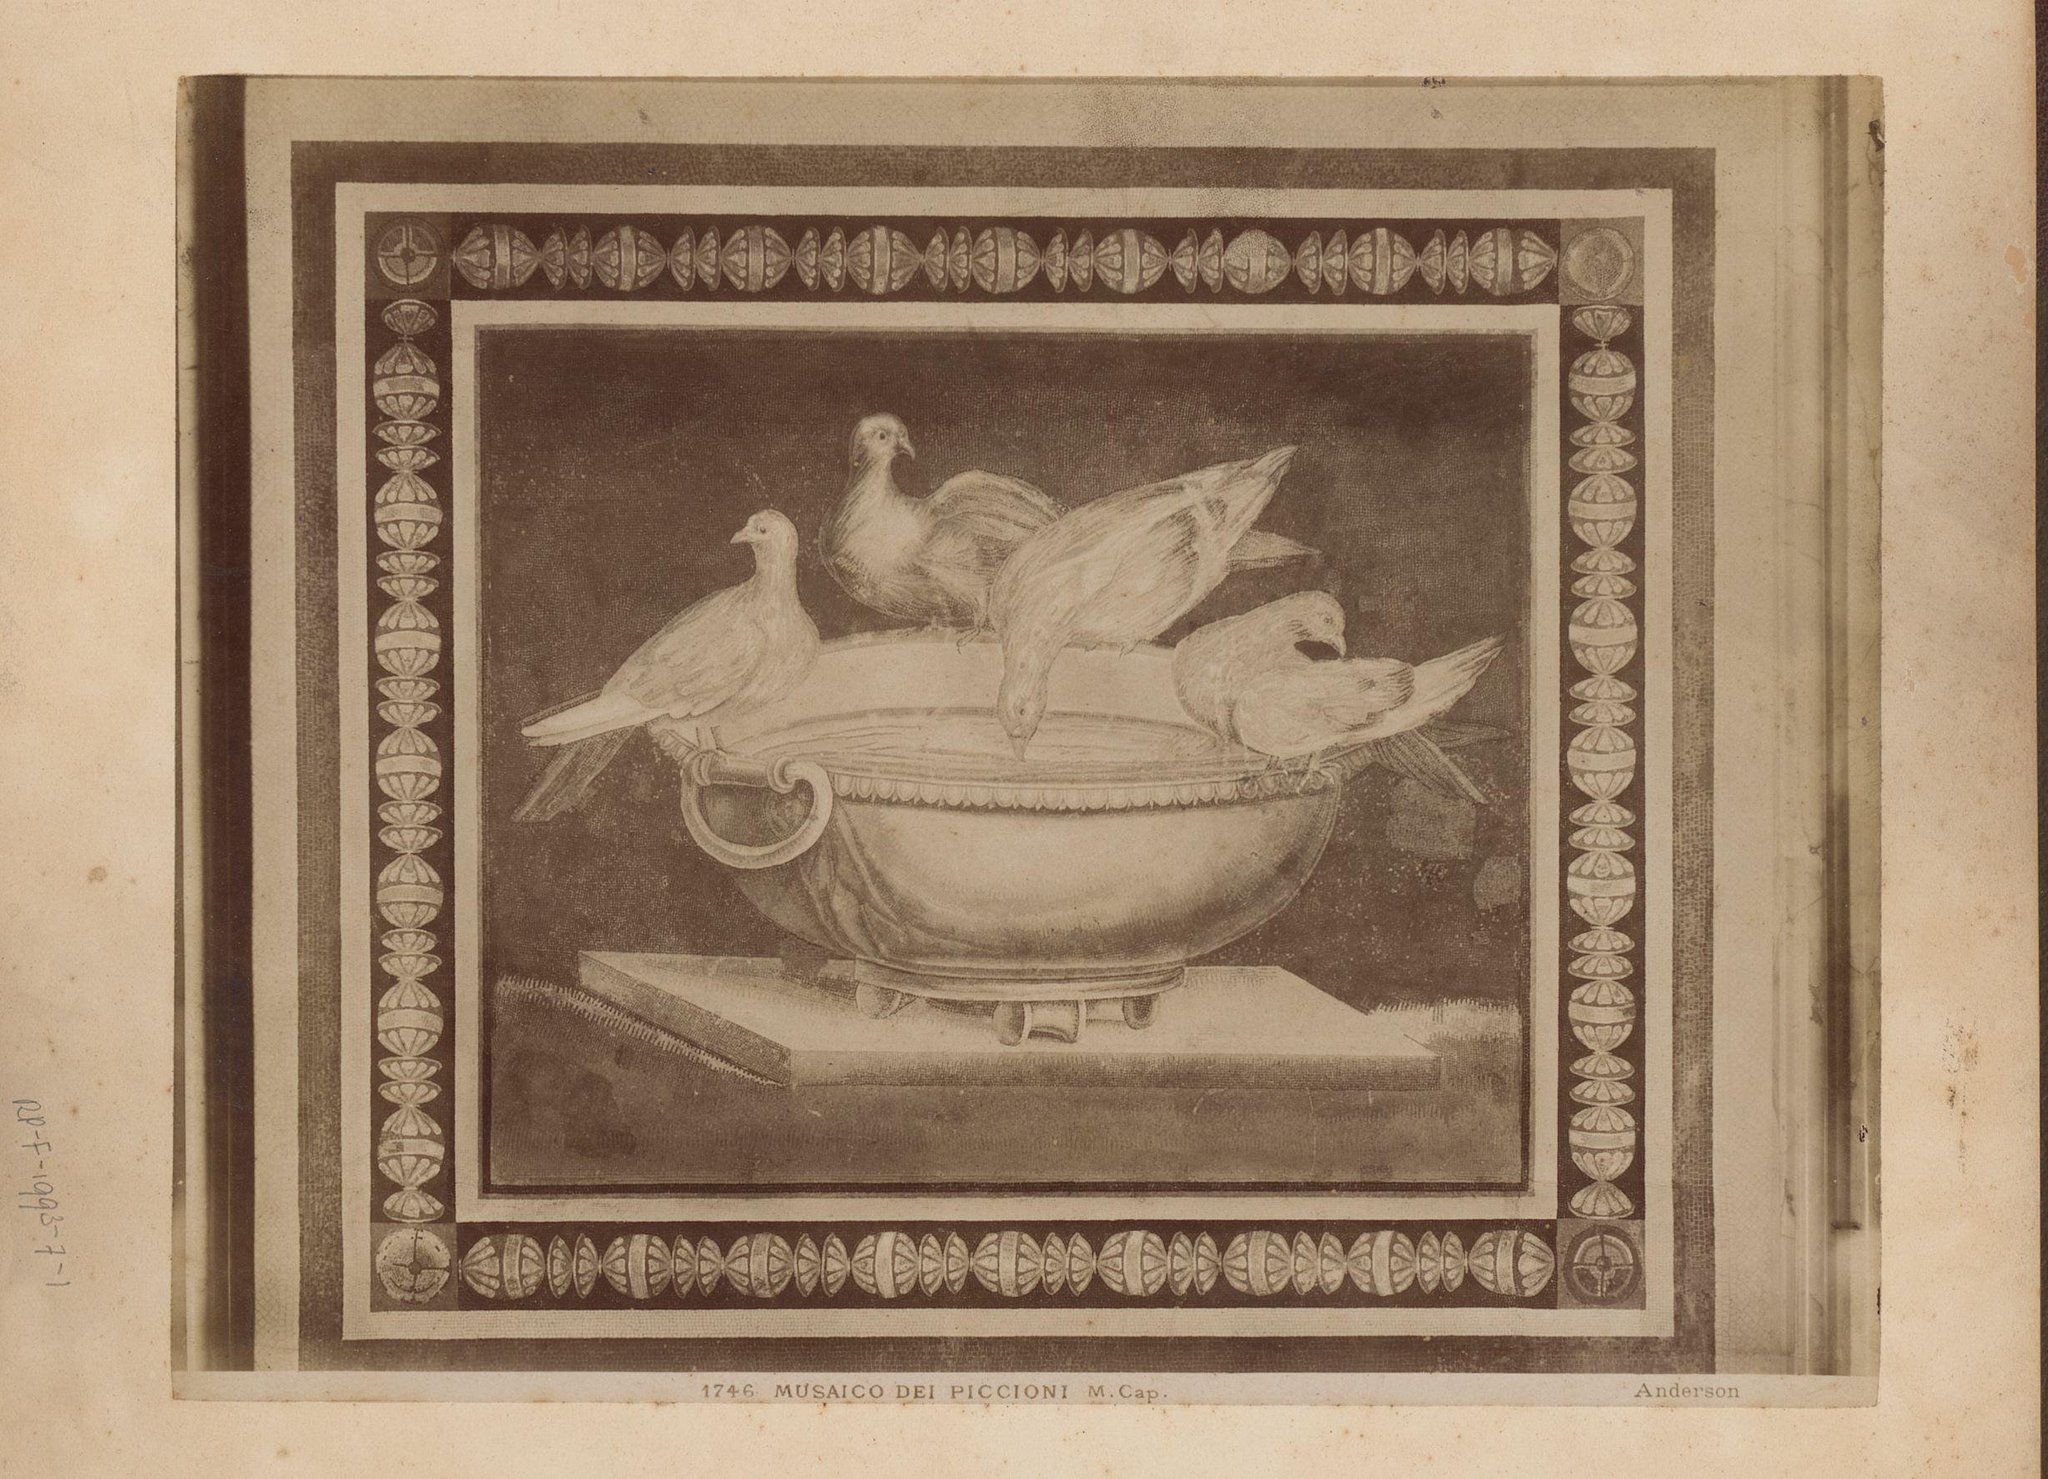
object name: album leaf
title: Fotoreproductie van mozaïek met duiven in de Capitolijnse Musea te Rome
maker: james anderson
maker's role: fotograaf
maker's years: 1813-1877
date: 1857-1875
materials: paper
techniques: albumen print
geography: capitolijnse musea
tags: doves, pigeons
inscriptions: inscription: ‘1746. Musaico dei Piccioni M. Cap. Anderson’